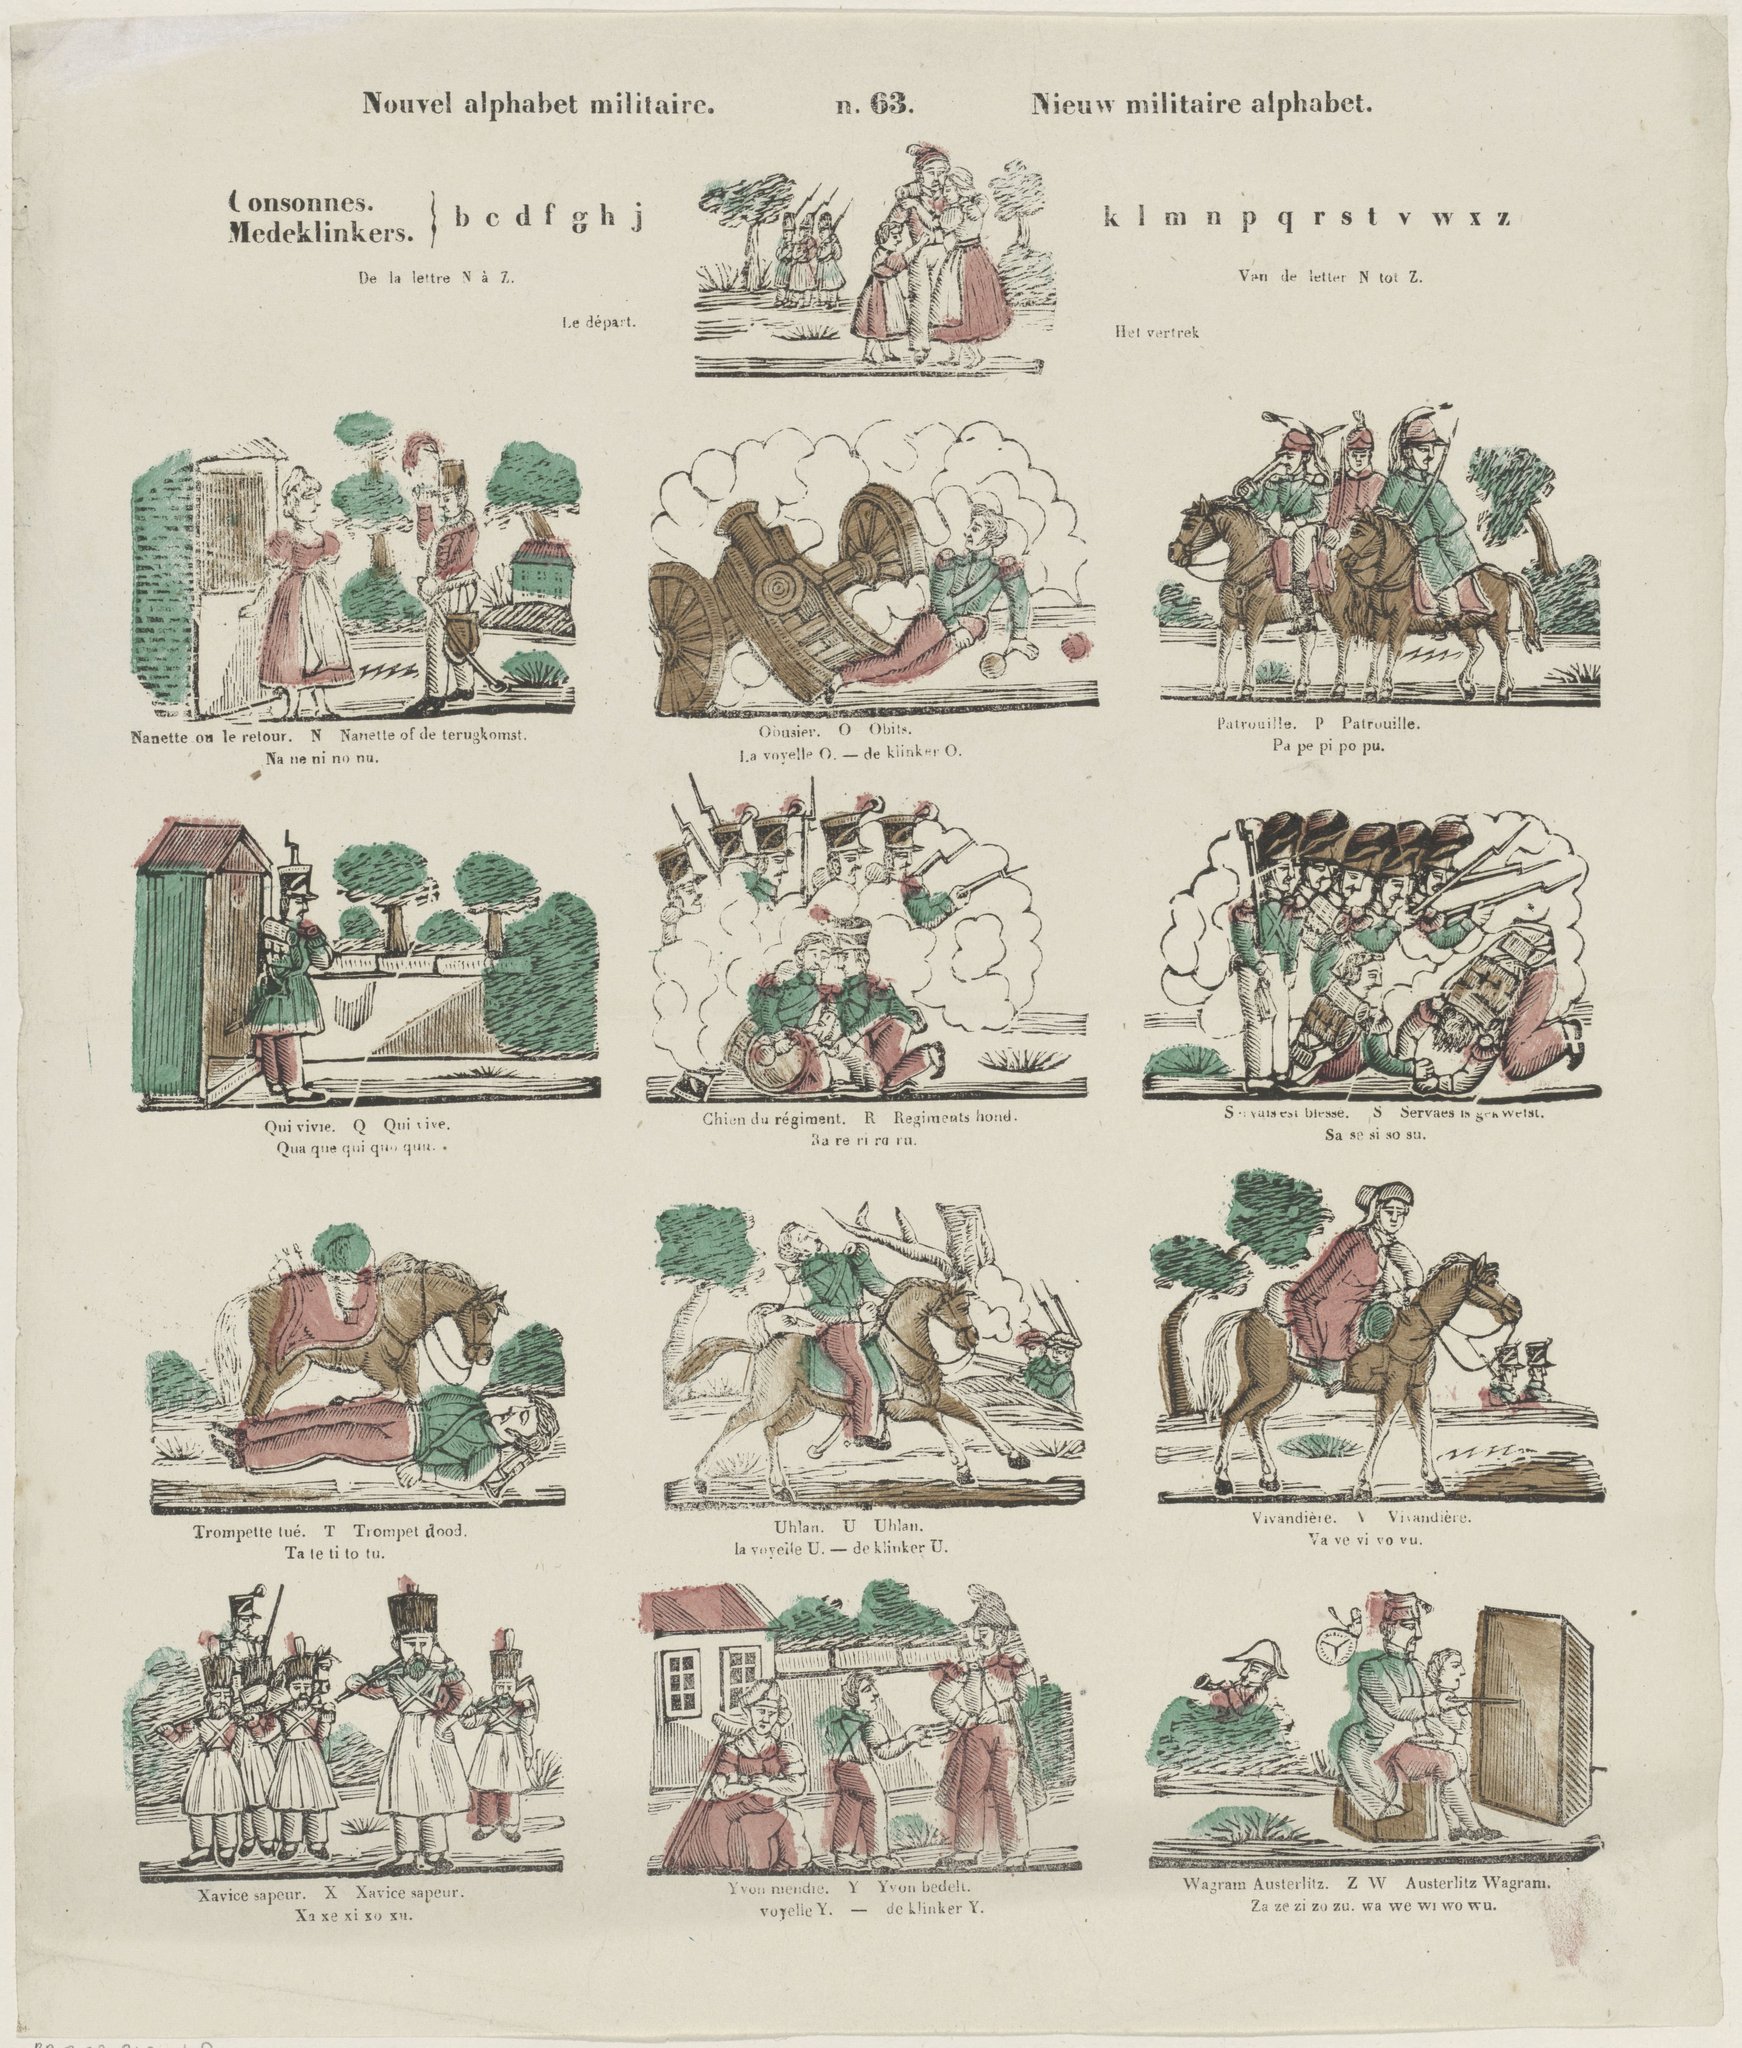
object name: popular print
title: Nouvel alphabet militaire / Nieuw militaire alphabet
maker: Anonymous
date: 1833-1900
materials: paper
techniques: colour, letterpress printing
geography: netherlands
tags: letters, alphabet, script, the soldier; the soldier's life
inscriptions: collector's mark: Lugt 2760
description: Blad met 12 voorstellingen van de letters van het alfabet (N-Z) geïllustreerd met militairen waarvan de woorden met de betreffende letter beginnen. Onder elke afbeelding een onderschrift in het Nederlands en in het Frans. Genummerd midden boven: n. 63.